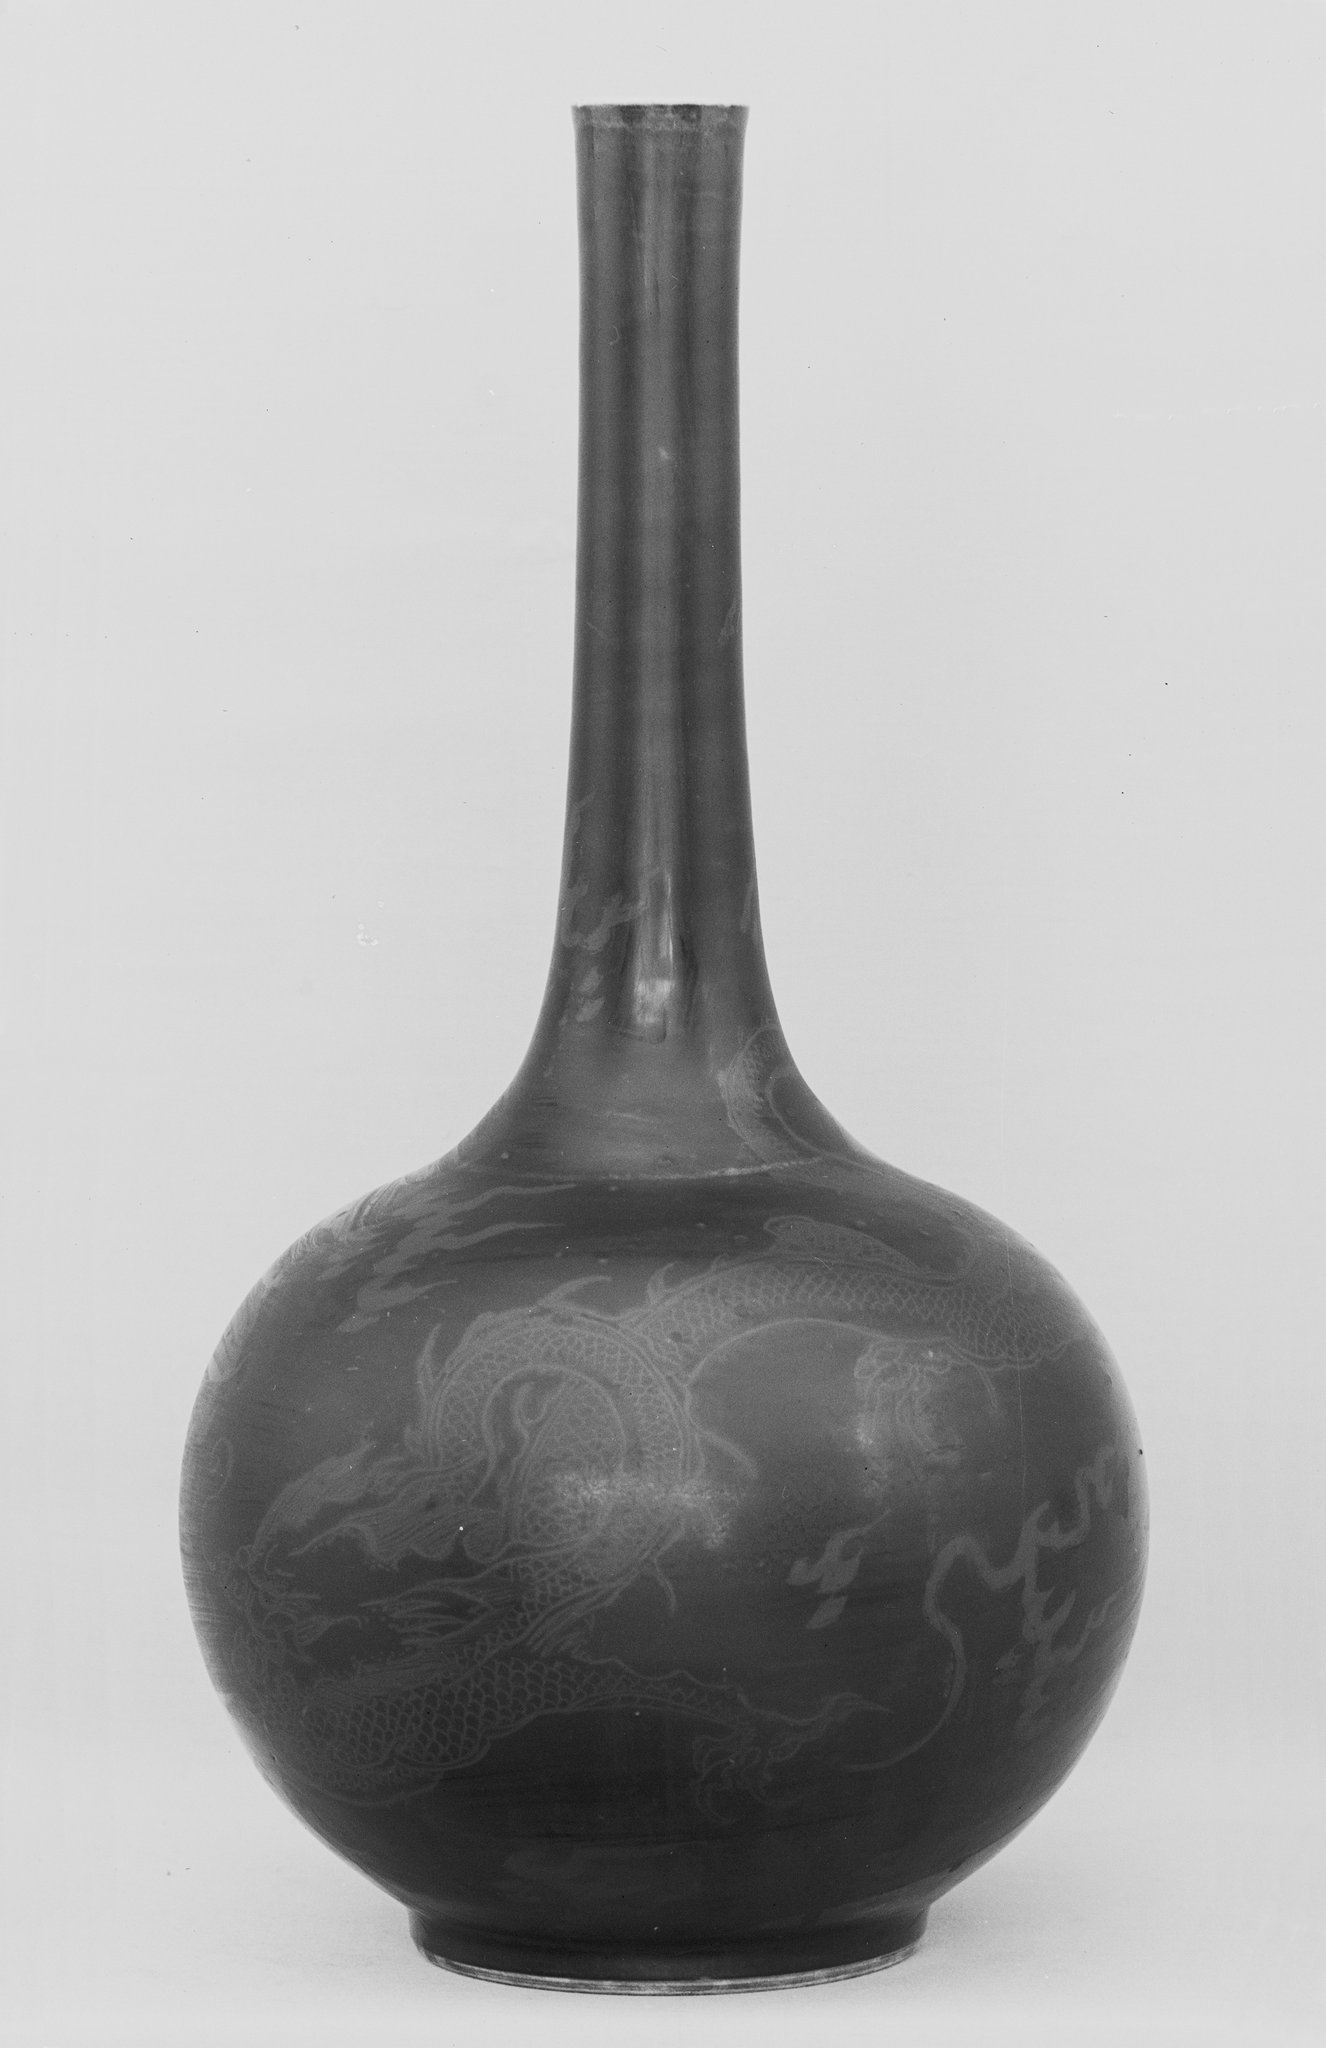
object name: vase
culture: chinese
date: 1801-1900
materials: glaze, iron, porcelain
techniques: overglaze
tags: dragons